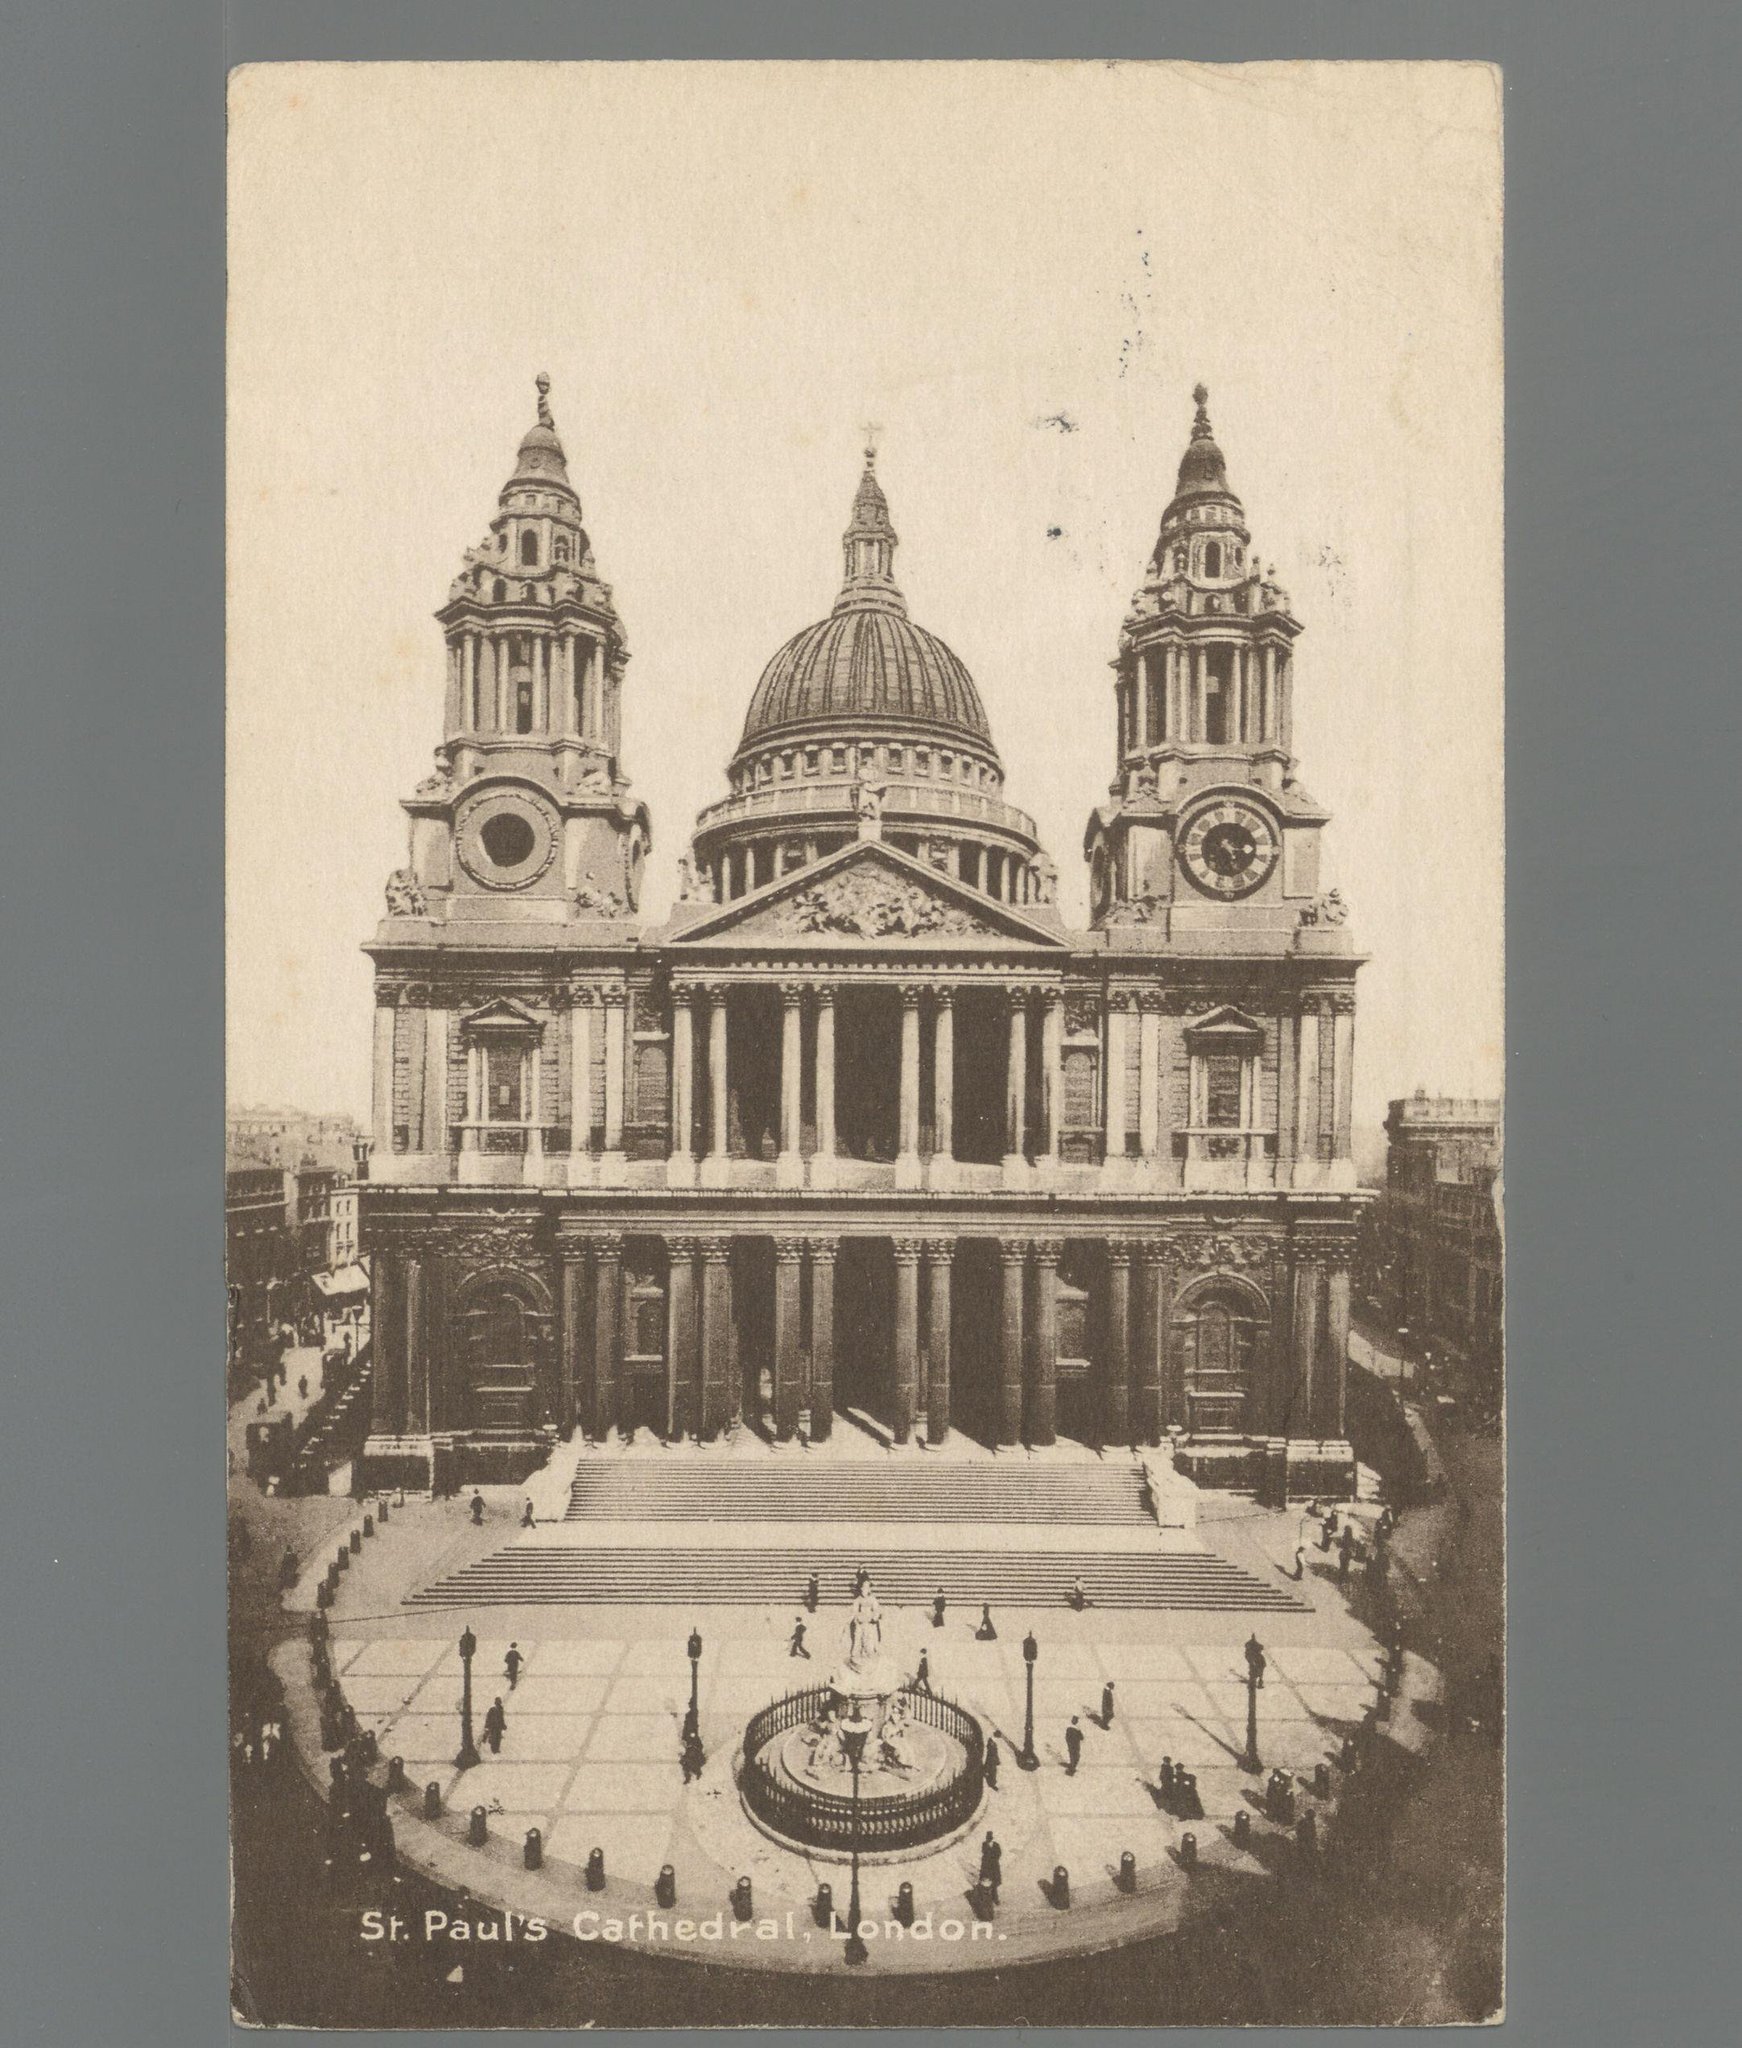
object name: photomechanical print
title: National Series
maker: Anonymous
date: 1902-1910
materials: cardboard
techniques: photograph, writing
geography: glasgow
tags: square, place, circus, etc., church (exterior)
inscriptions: postage stamp